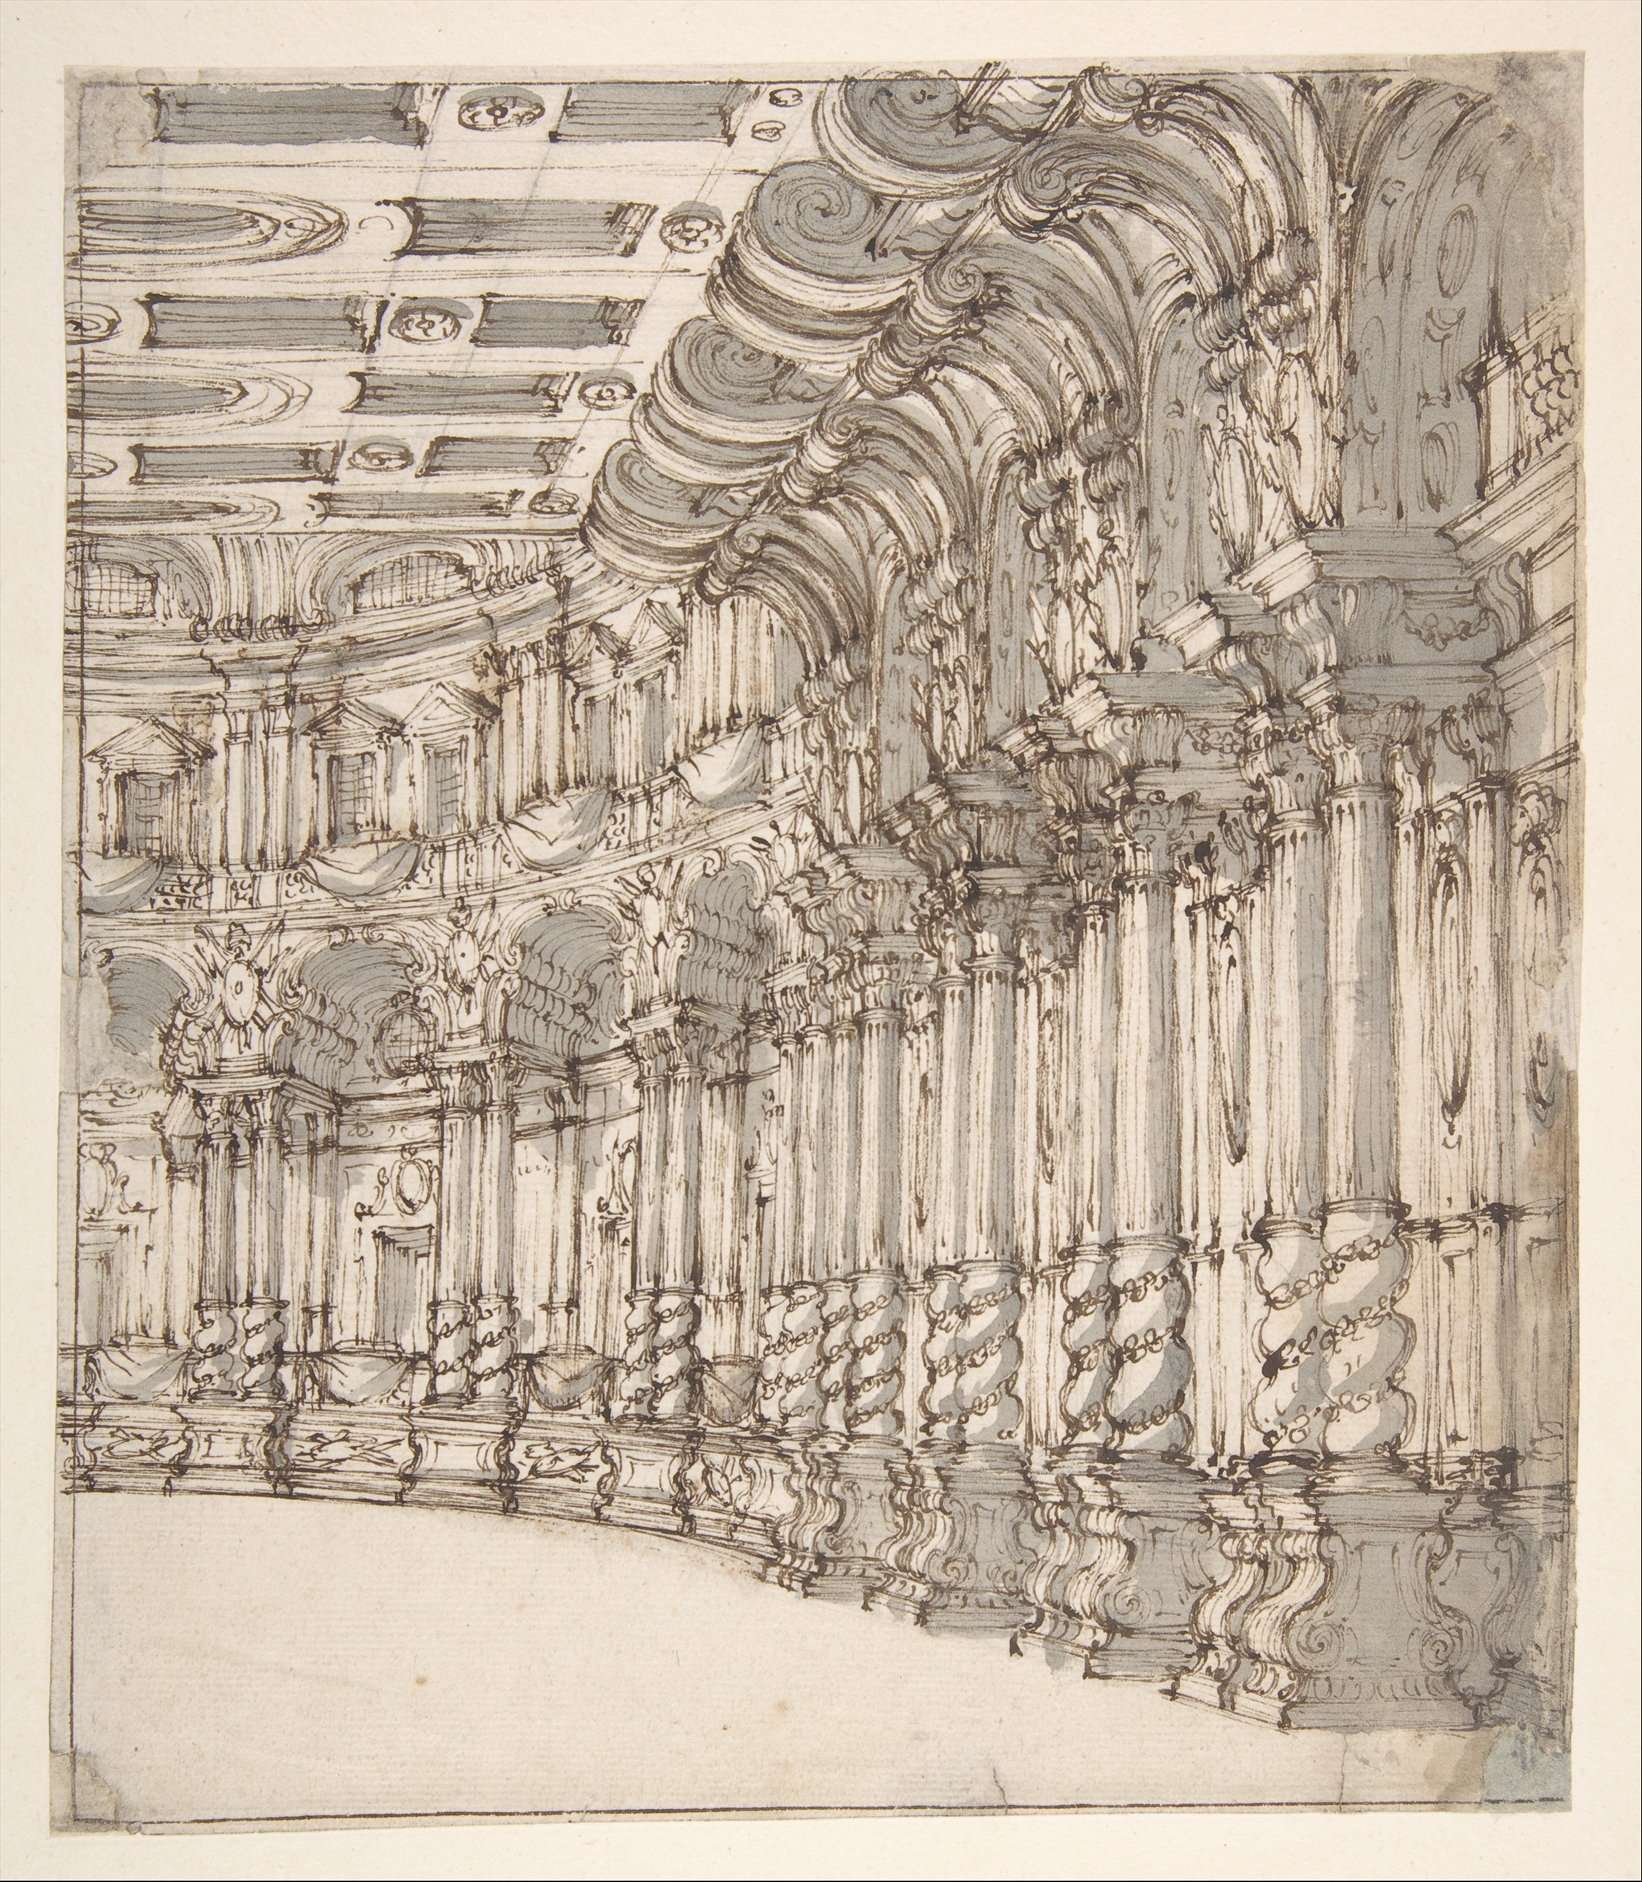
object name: drawing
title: Design for a Stage Set: Interior of a Ballroom or Theater with Torqued Columns and Large Volutes Above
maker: francesco galli bibiena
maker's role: artist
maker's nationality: italian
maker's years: 1659-1739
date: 1676-1736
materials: graphite, ink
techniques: brush, pen, wash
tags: columns,stage design